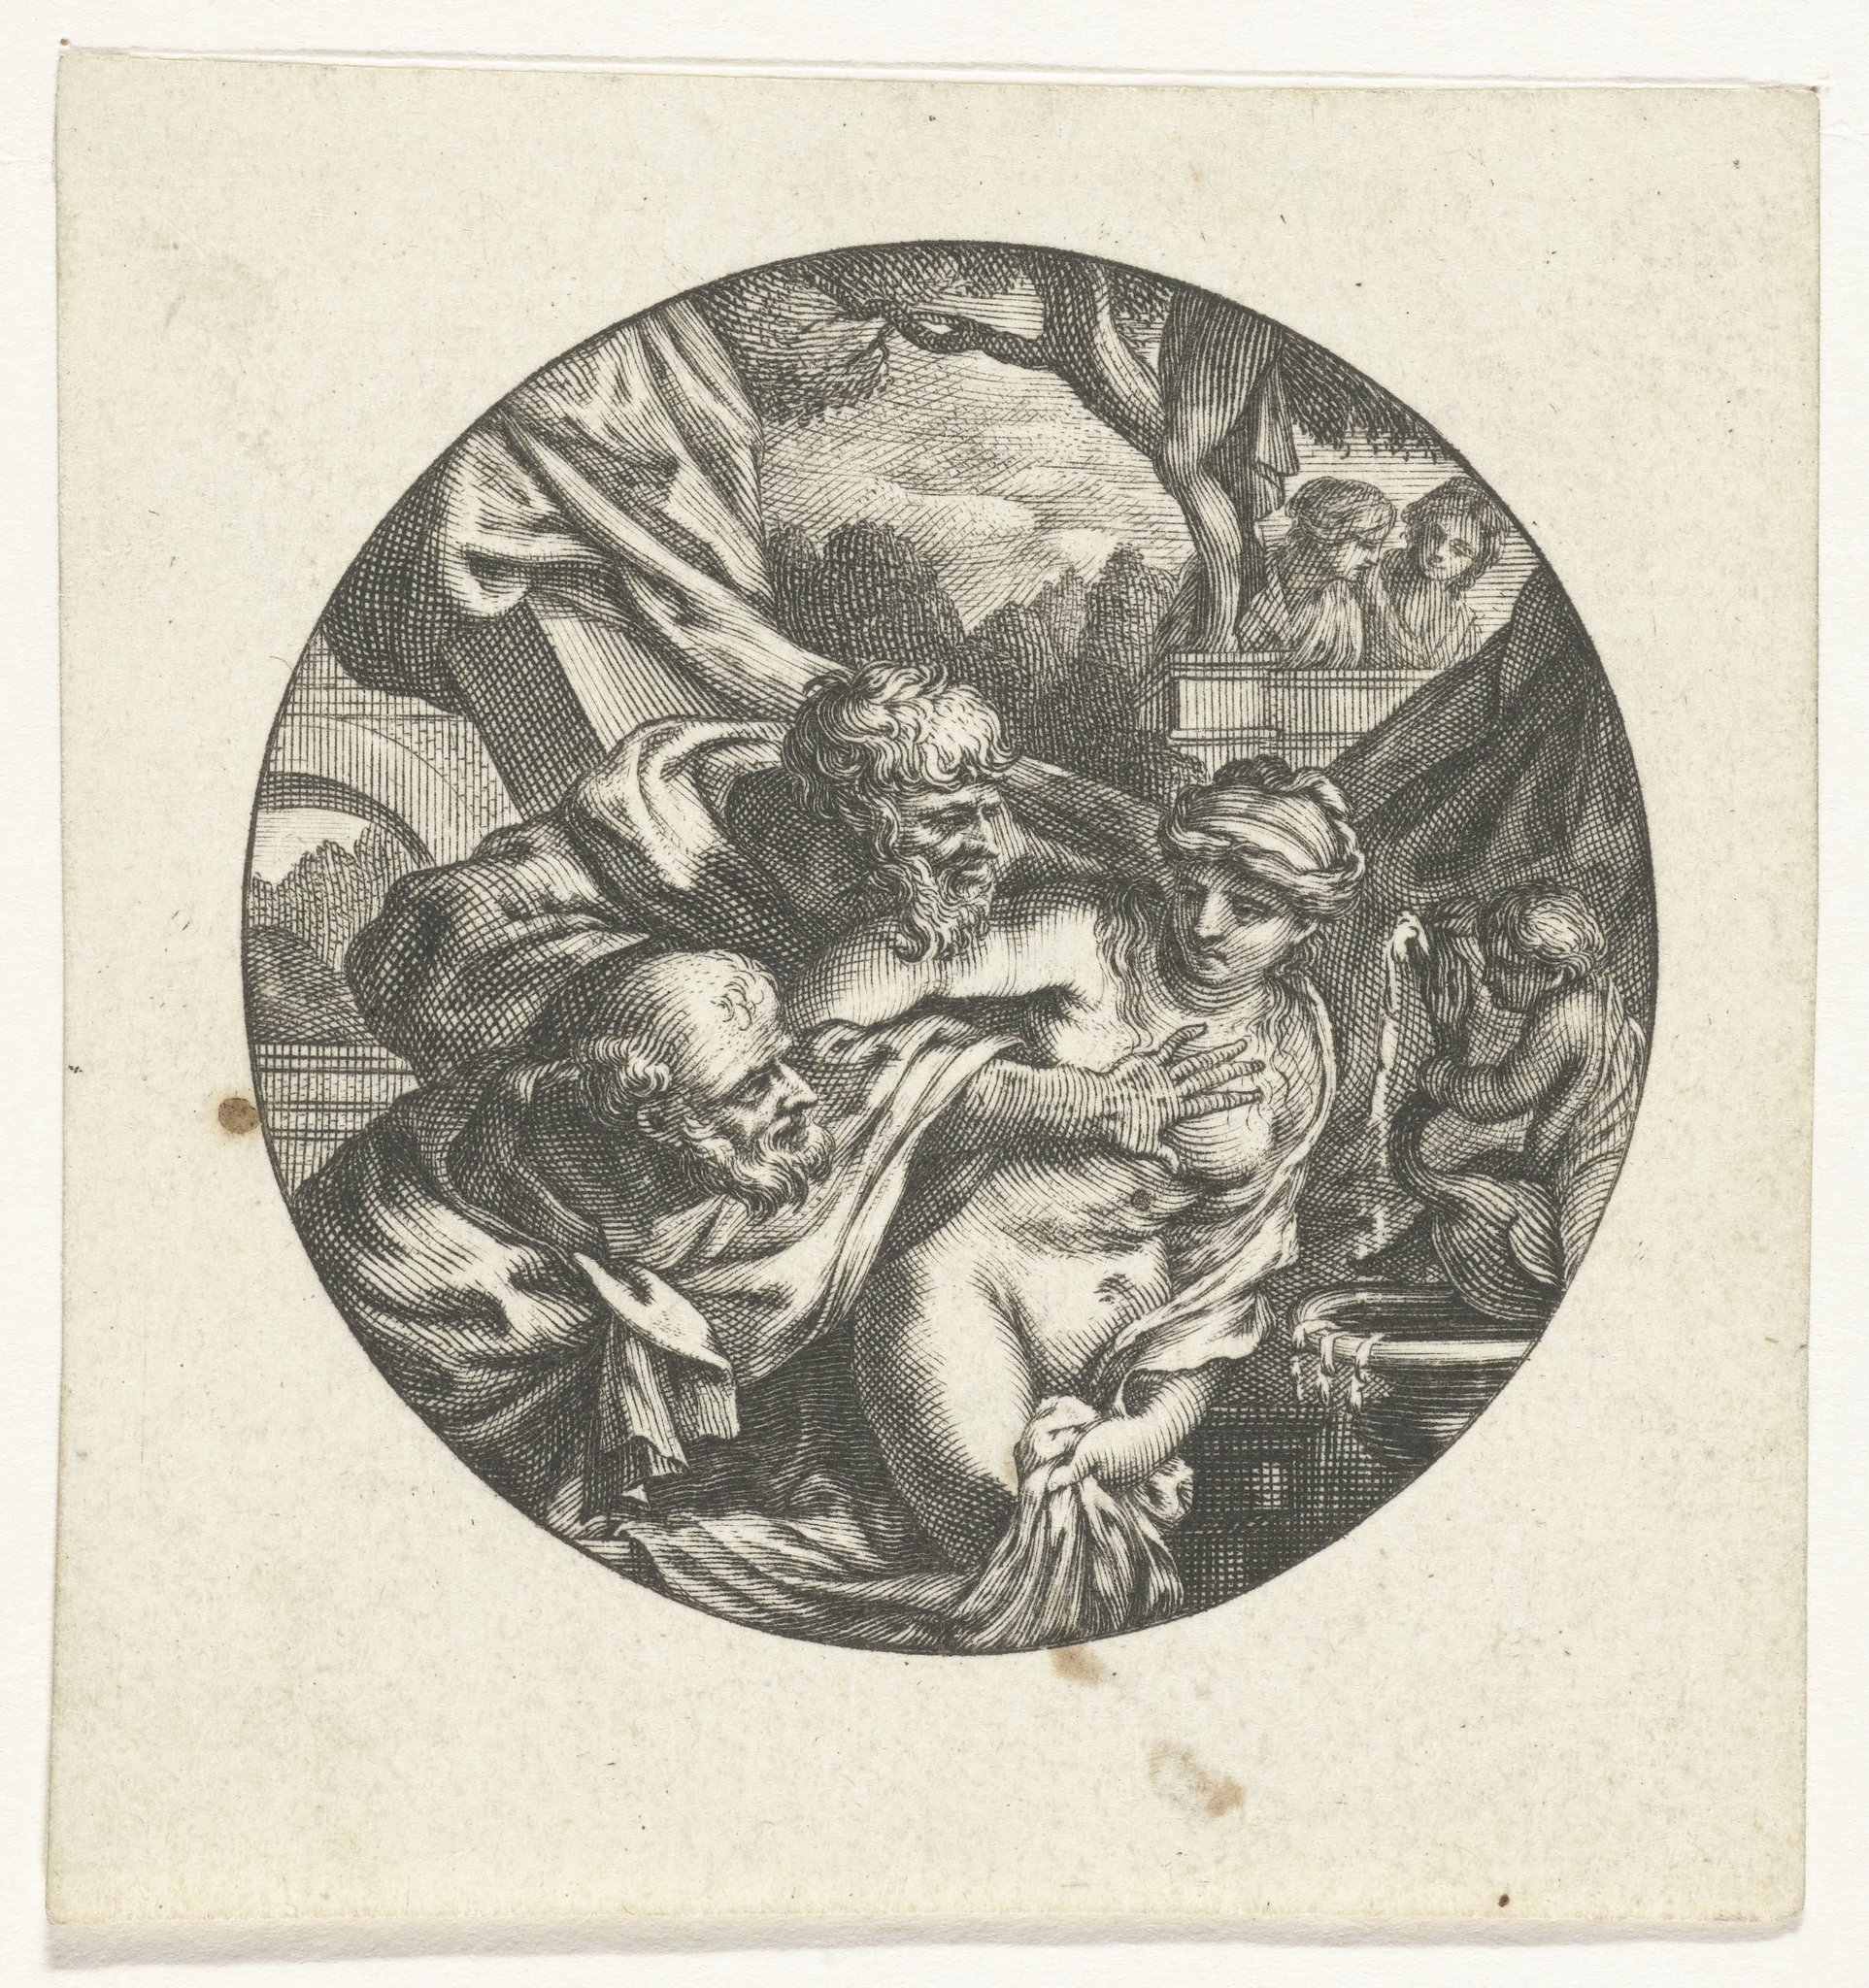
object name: print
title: Horlogekast met Susanna en de ouderlingen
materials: paper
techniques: engraving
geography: france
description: Uitgeknipt, oorspronkelijk afgedrukt op een blad temidden van twee stroken. Tweede druk.